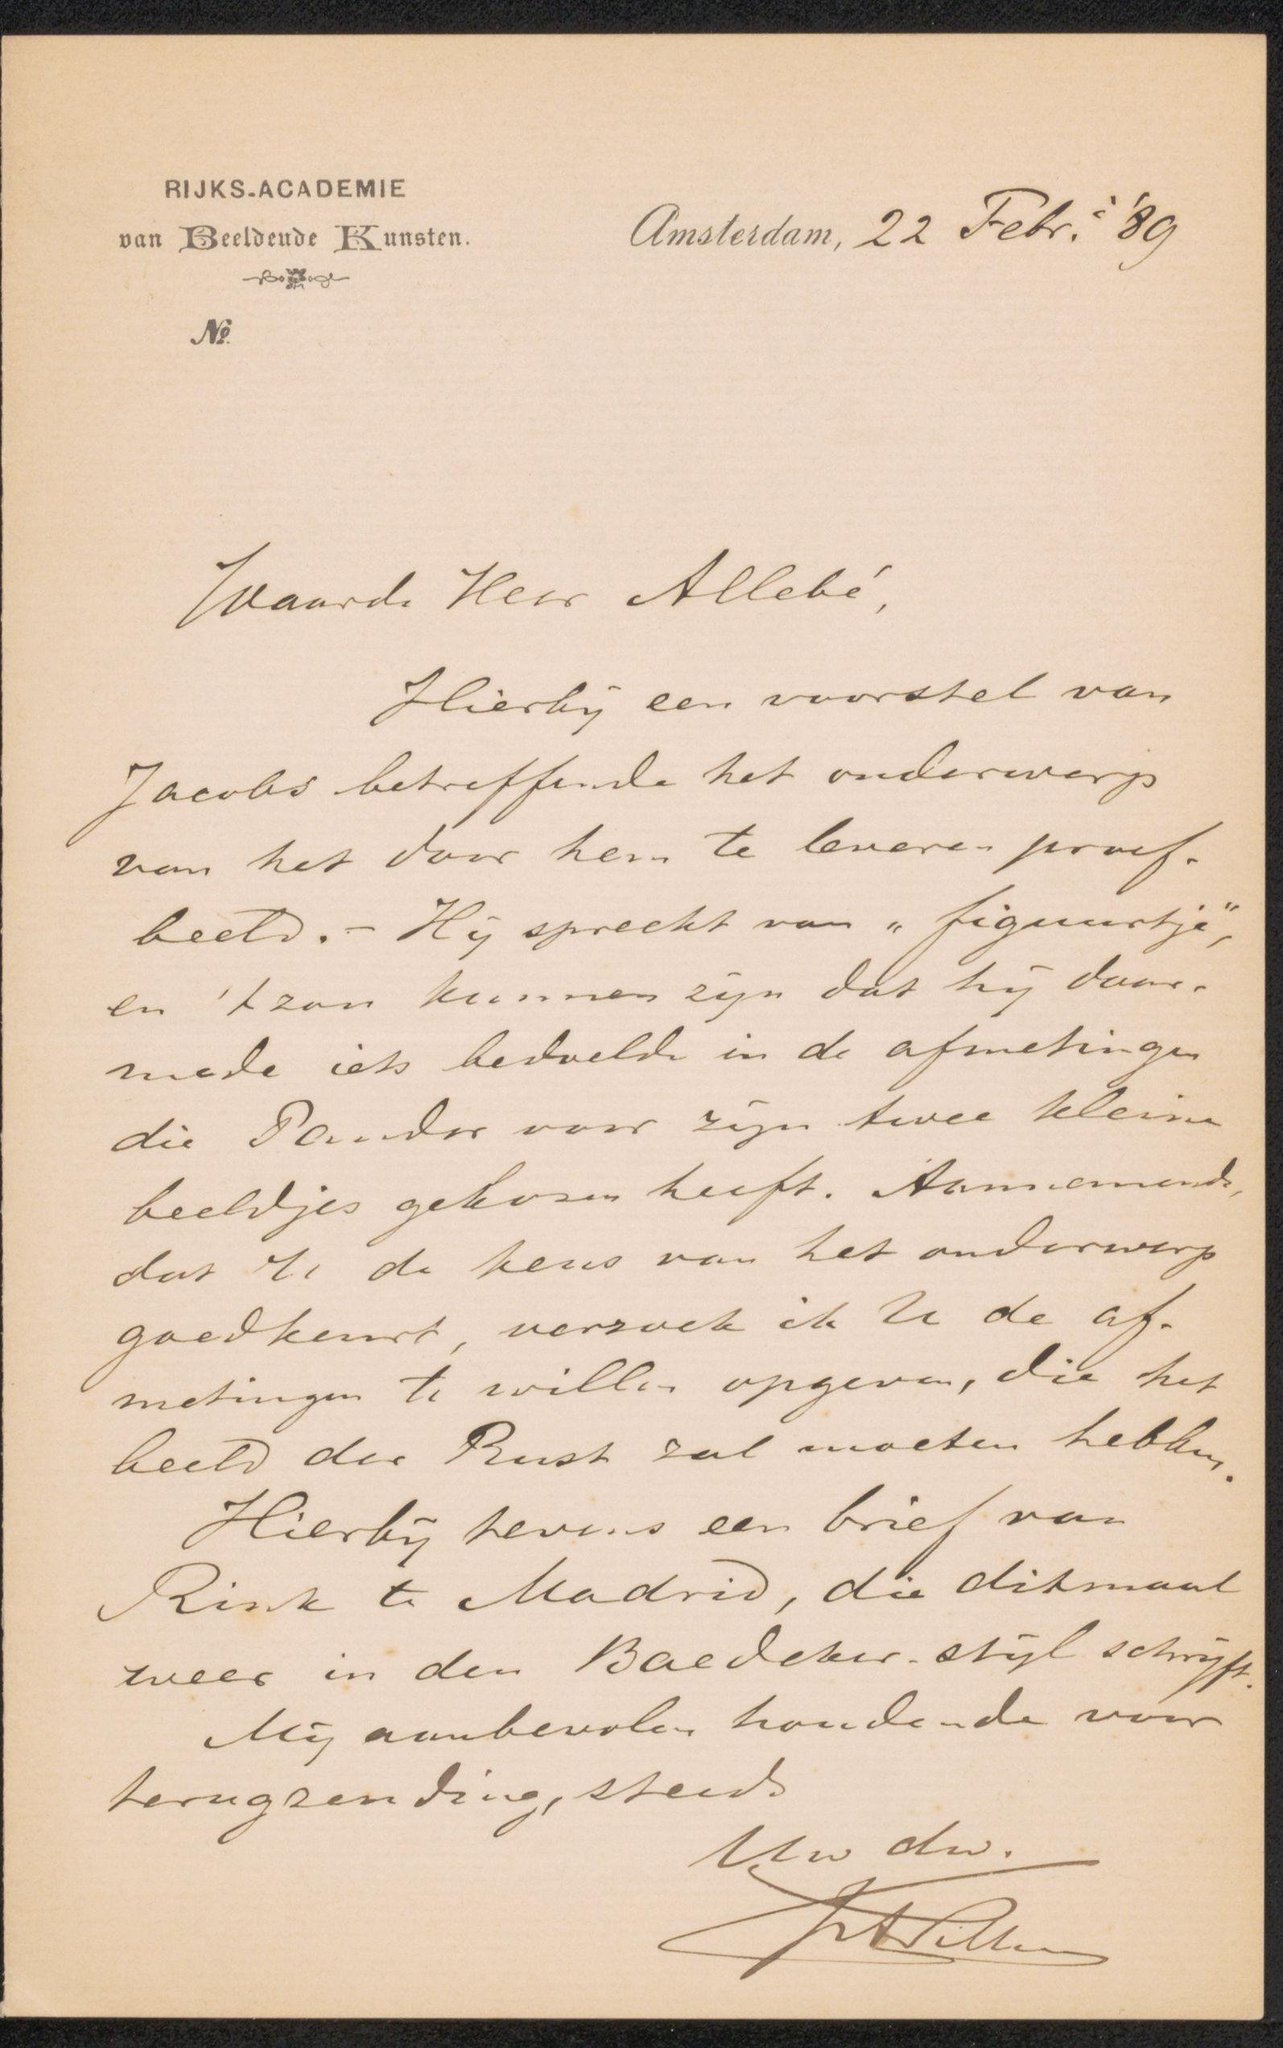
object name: letter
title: Brief aan August Allebé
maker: jérôme alexander sillem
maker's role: politician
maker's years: 1840-1912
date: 1889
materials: ink, paper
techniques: pen, printing, writing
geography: amsterdam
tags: essen, publisher, karl baedeker, print maker, draughtsman, august allebé, veghel, paul rink, rome, designer, pier pander, painter, sculptor, sculpture